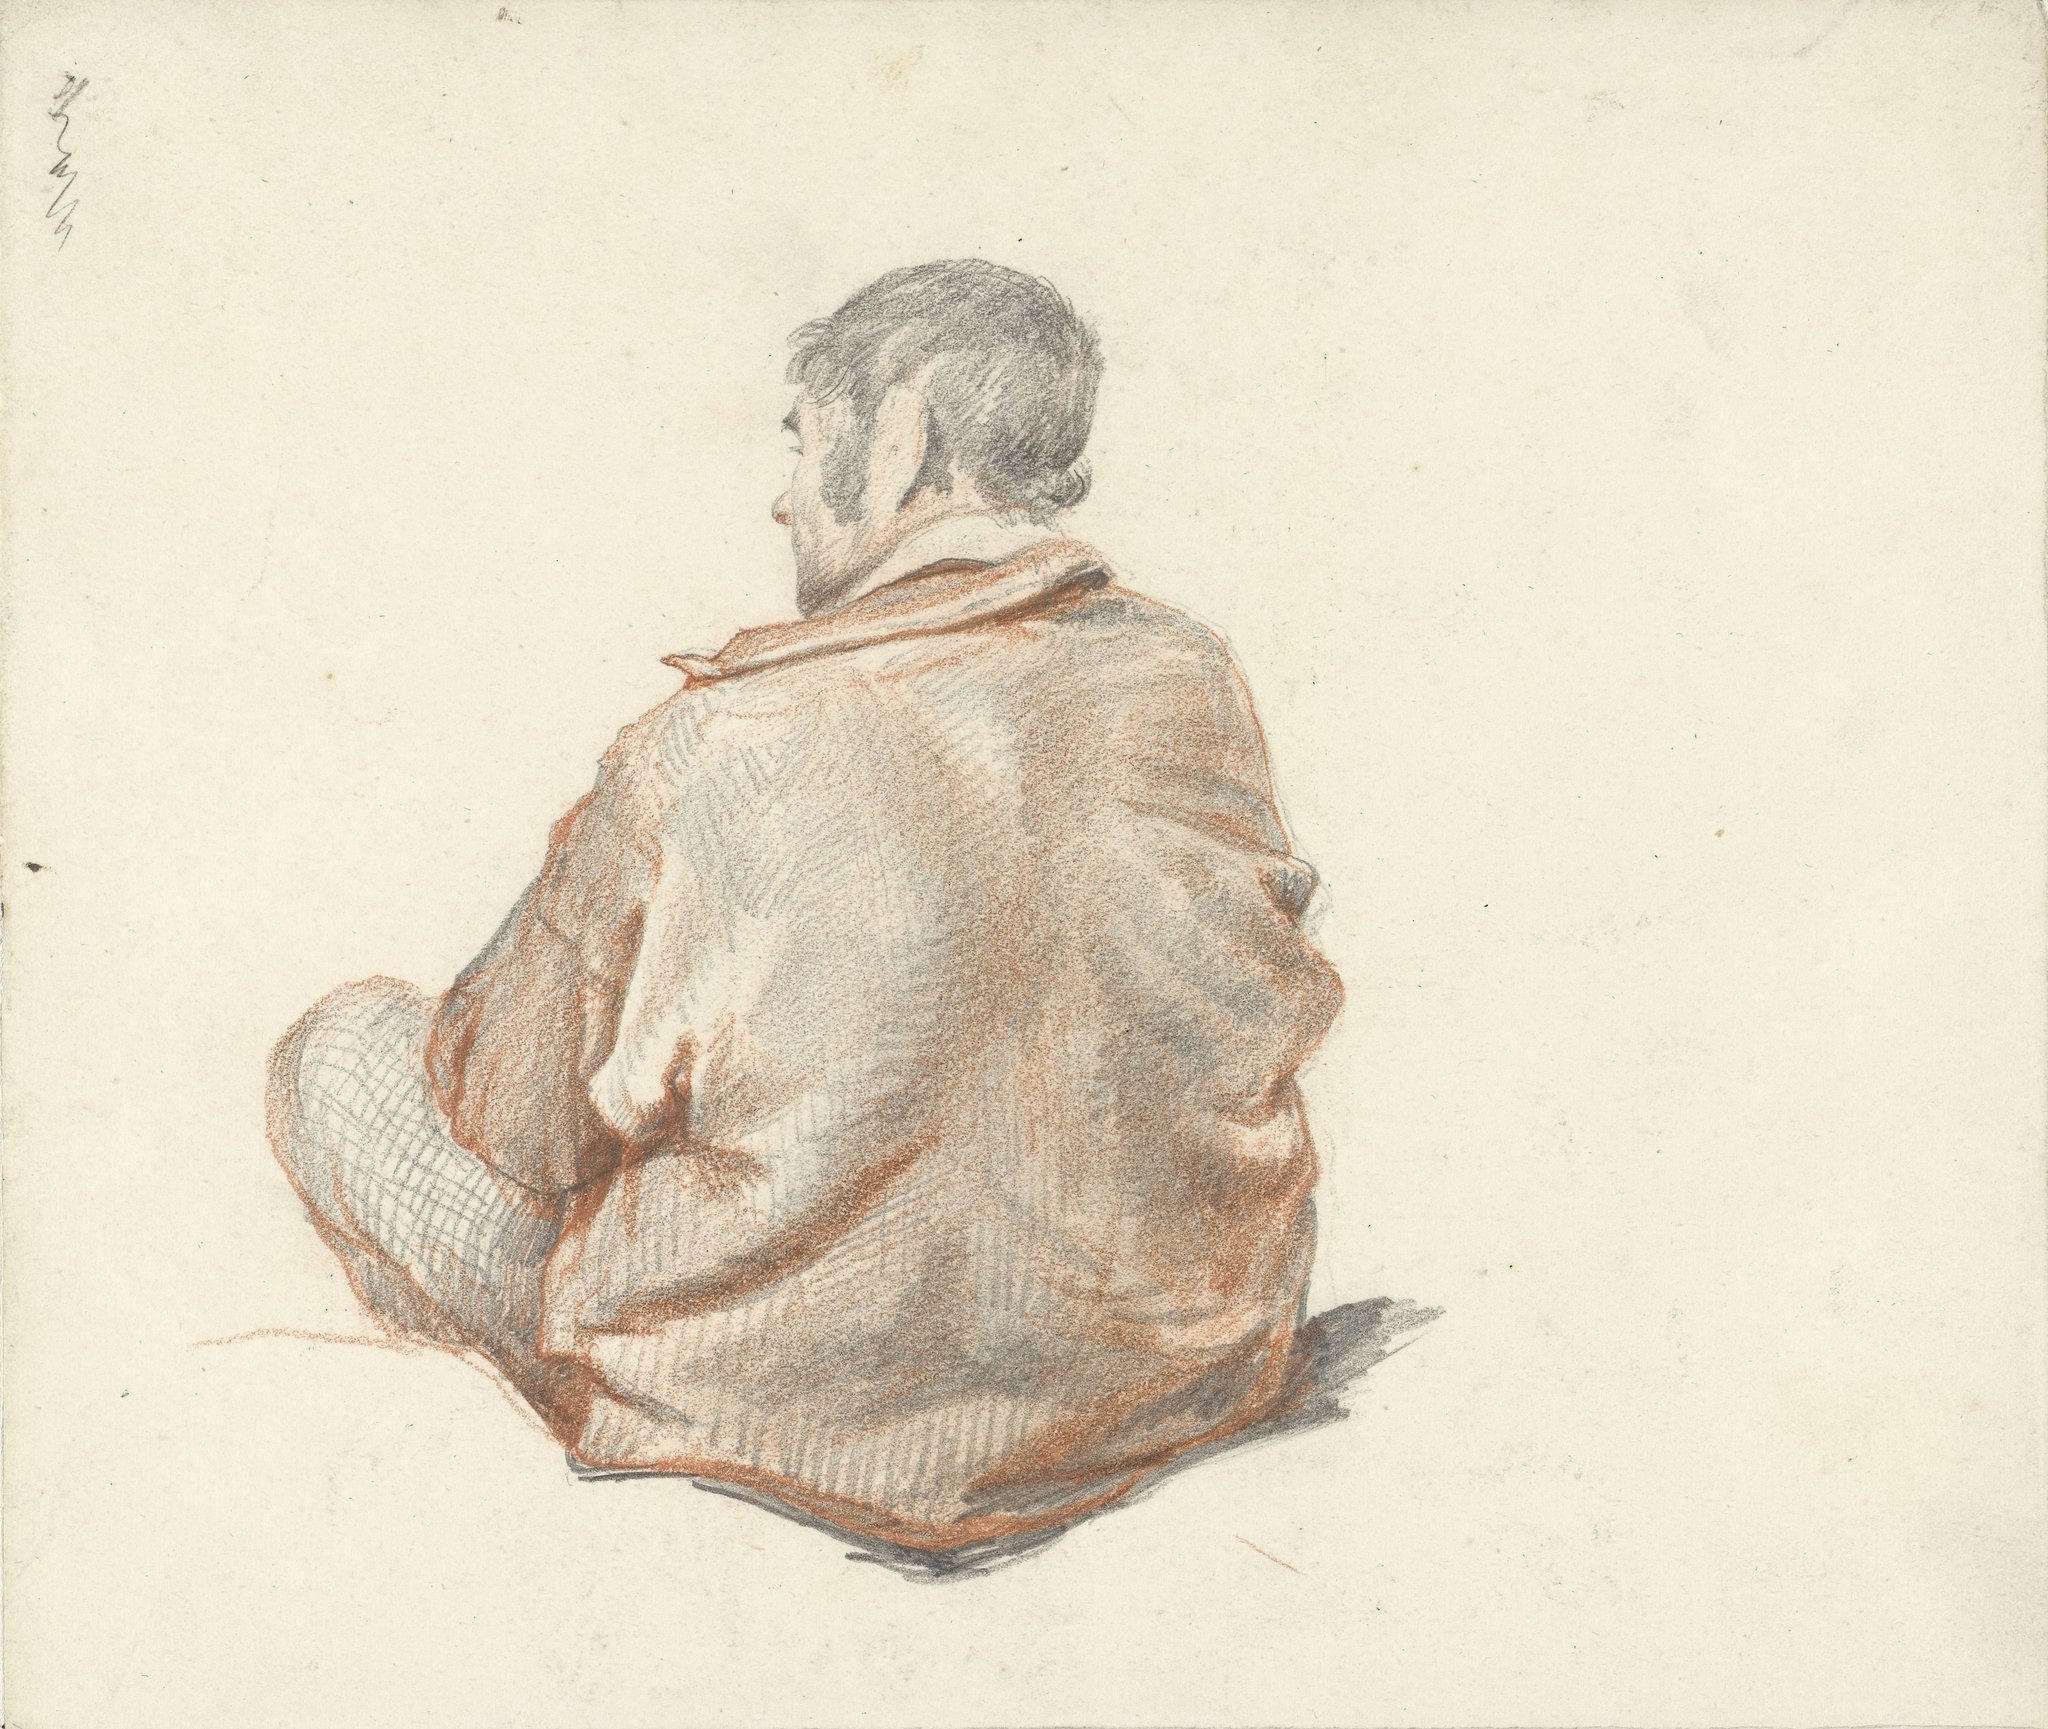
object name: drawing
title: Zittende man, op de rug gezien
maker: guillaume anne van der brugghen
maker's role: draughtsman, print maker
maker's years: 1812-1891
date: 1821-1891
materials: chalk, paper, pencil